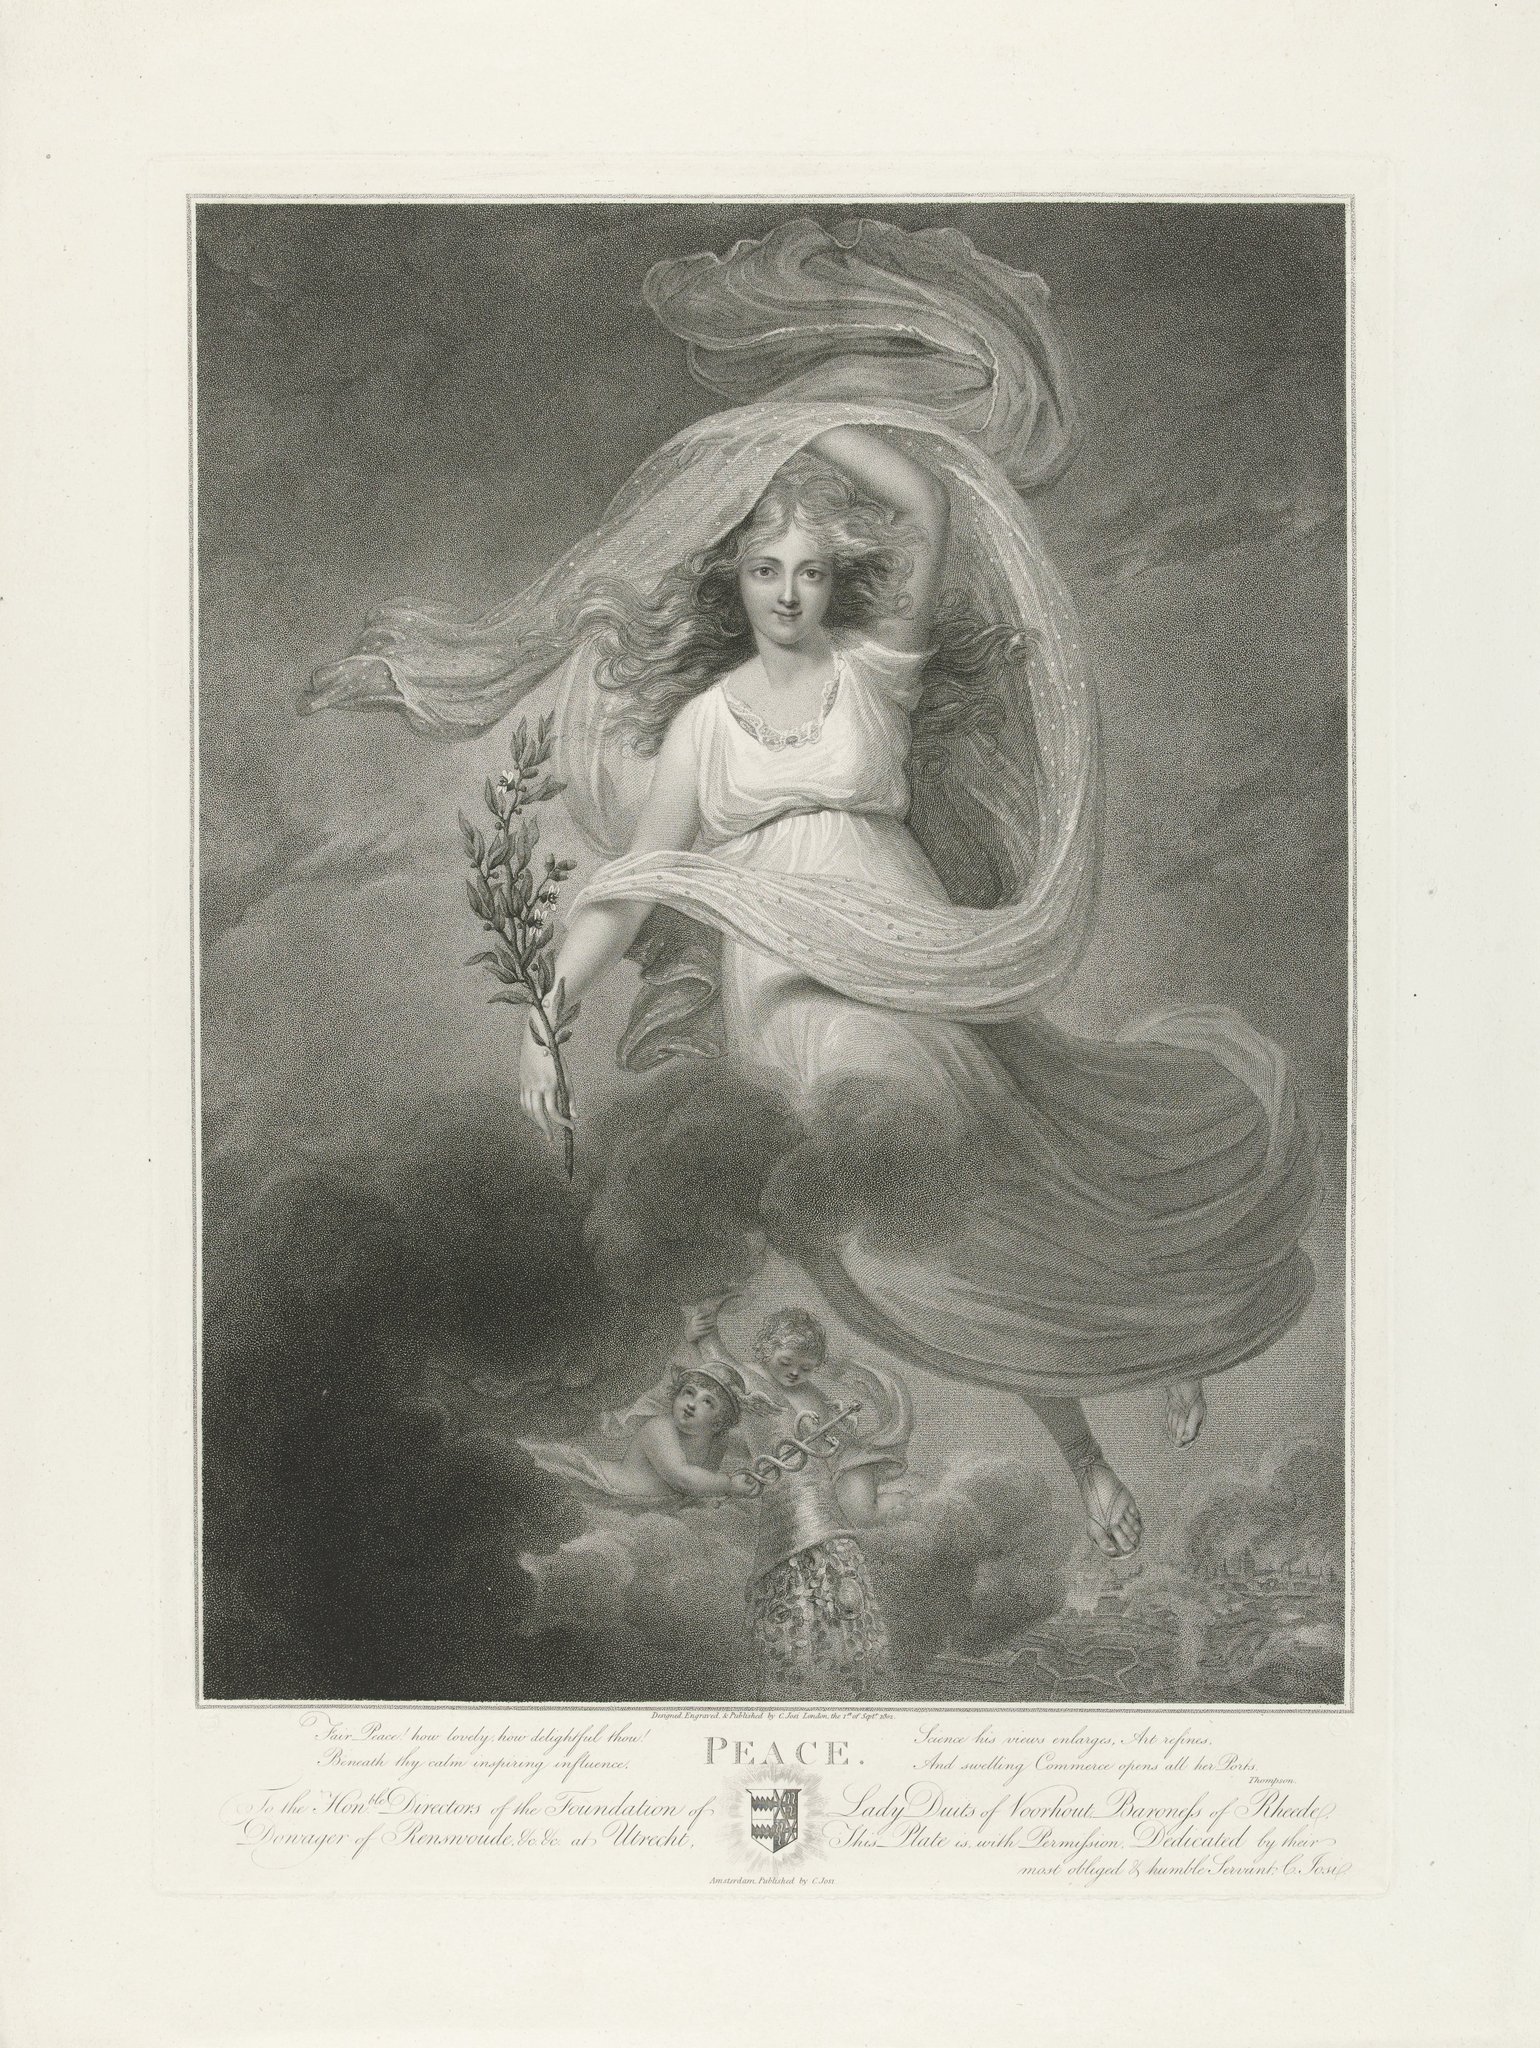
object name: print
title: Allegorie op de Vrede van Amiens, 1802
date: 1802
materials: paper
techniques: aquatint, etching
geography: amsterdam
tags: symbols, allegories of peace, 'pax'; 'pace' (ripa), attributes of mercury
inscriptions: collector's mark: Lugt 574, collector's mark: Lugt 2233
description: Allegorie op de Vrede van Amiens, op 27 maart 1802, die een einde maakte aan de oorlog tussen Groot-Brittannië en de Franse republiek, Spanje en de Bataafse Republiek. Centraal zweeft de Vrede door de wolken met een olijftak in de hand. Onderaan twee putti (Koophandel en Overvloed) met een hoorn van overvloed, rechts een stad verwoest door de oorlog. In het onderschrift een vierregelig vers in het Engels en het wapen van de fundatie. Bij de prent behoort een verklaring.